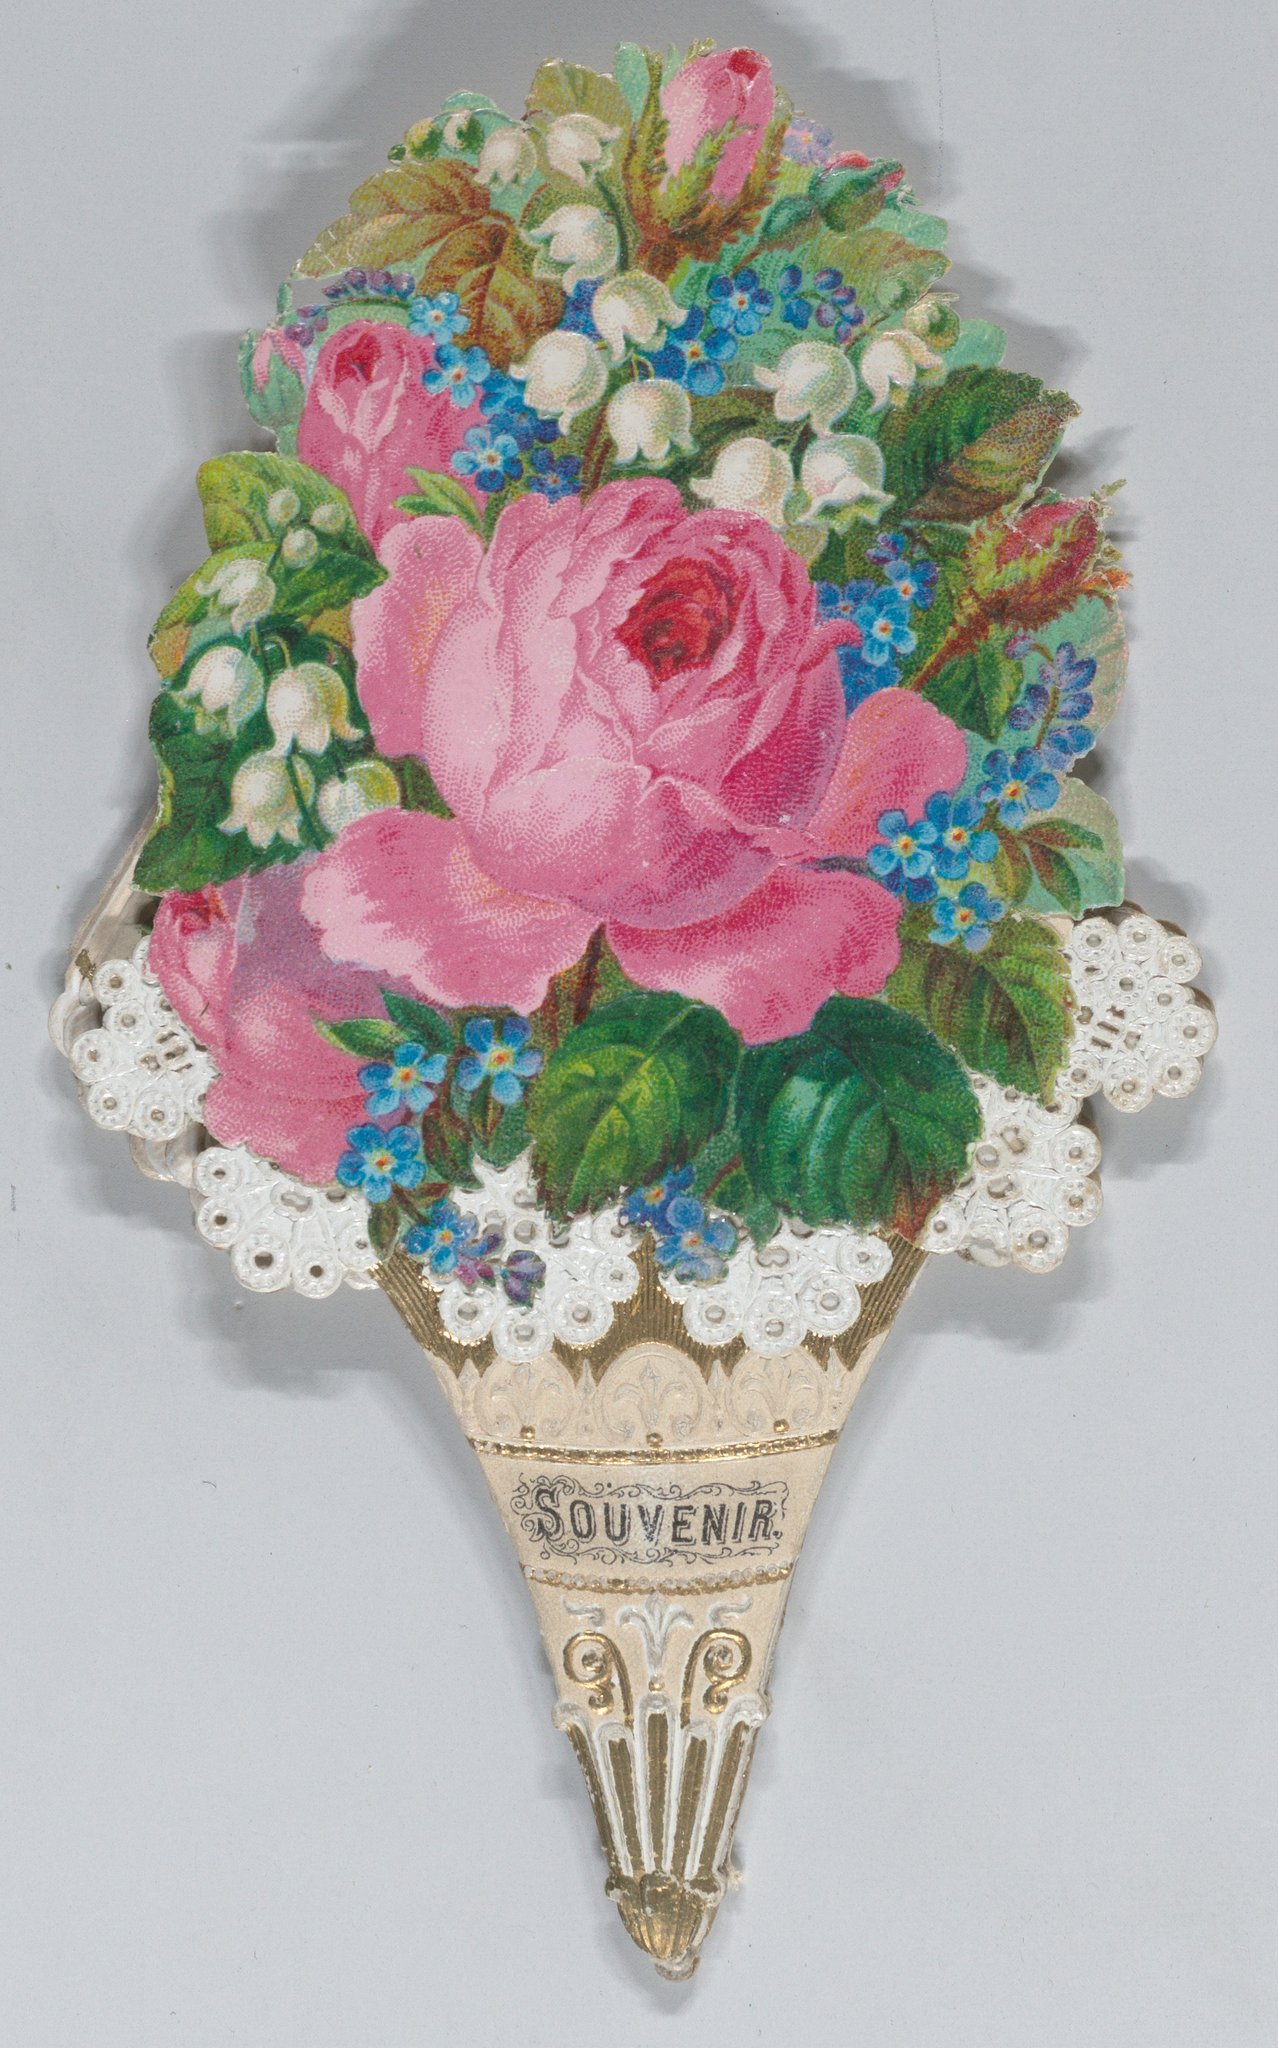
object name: valentine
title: Valentine - Mechanical - elaborate nosegay, fan souvenir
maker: anonymous, british, 19th century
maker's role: artist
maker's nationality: british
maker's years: 1800-1900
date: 1875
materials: gilt, thread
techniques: chromolithography, cutting, sewing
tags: flowers